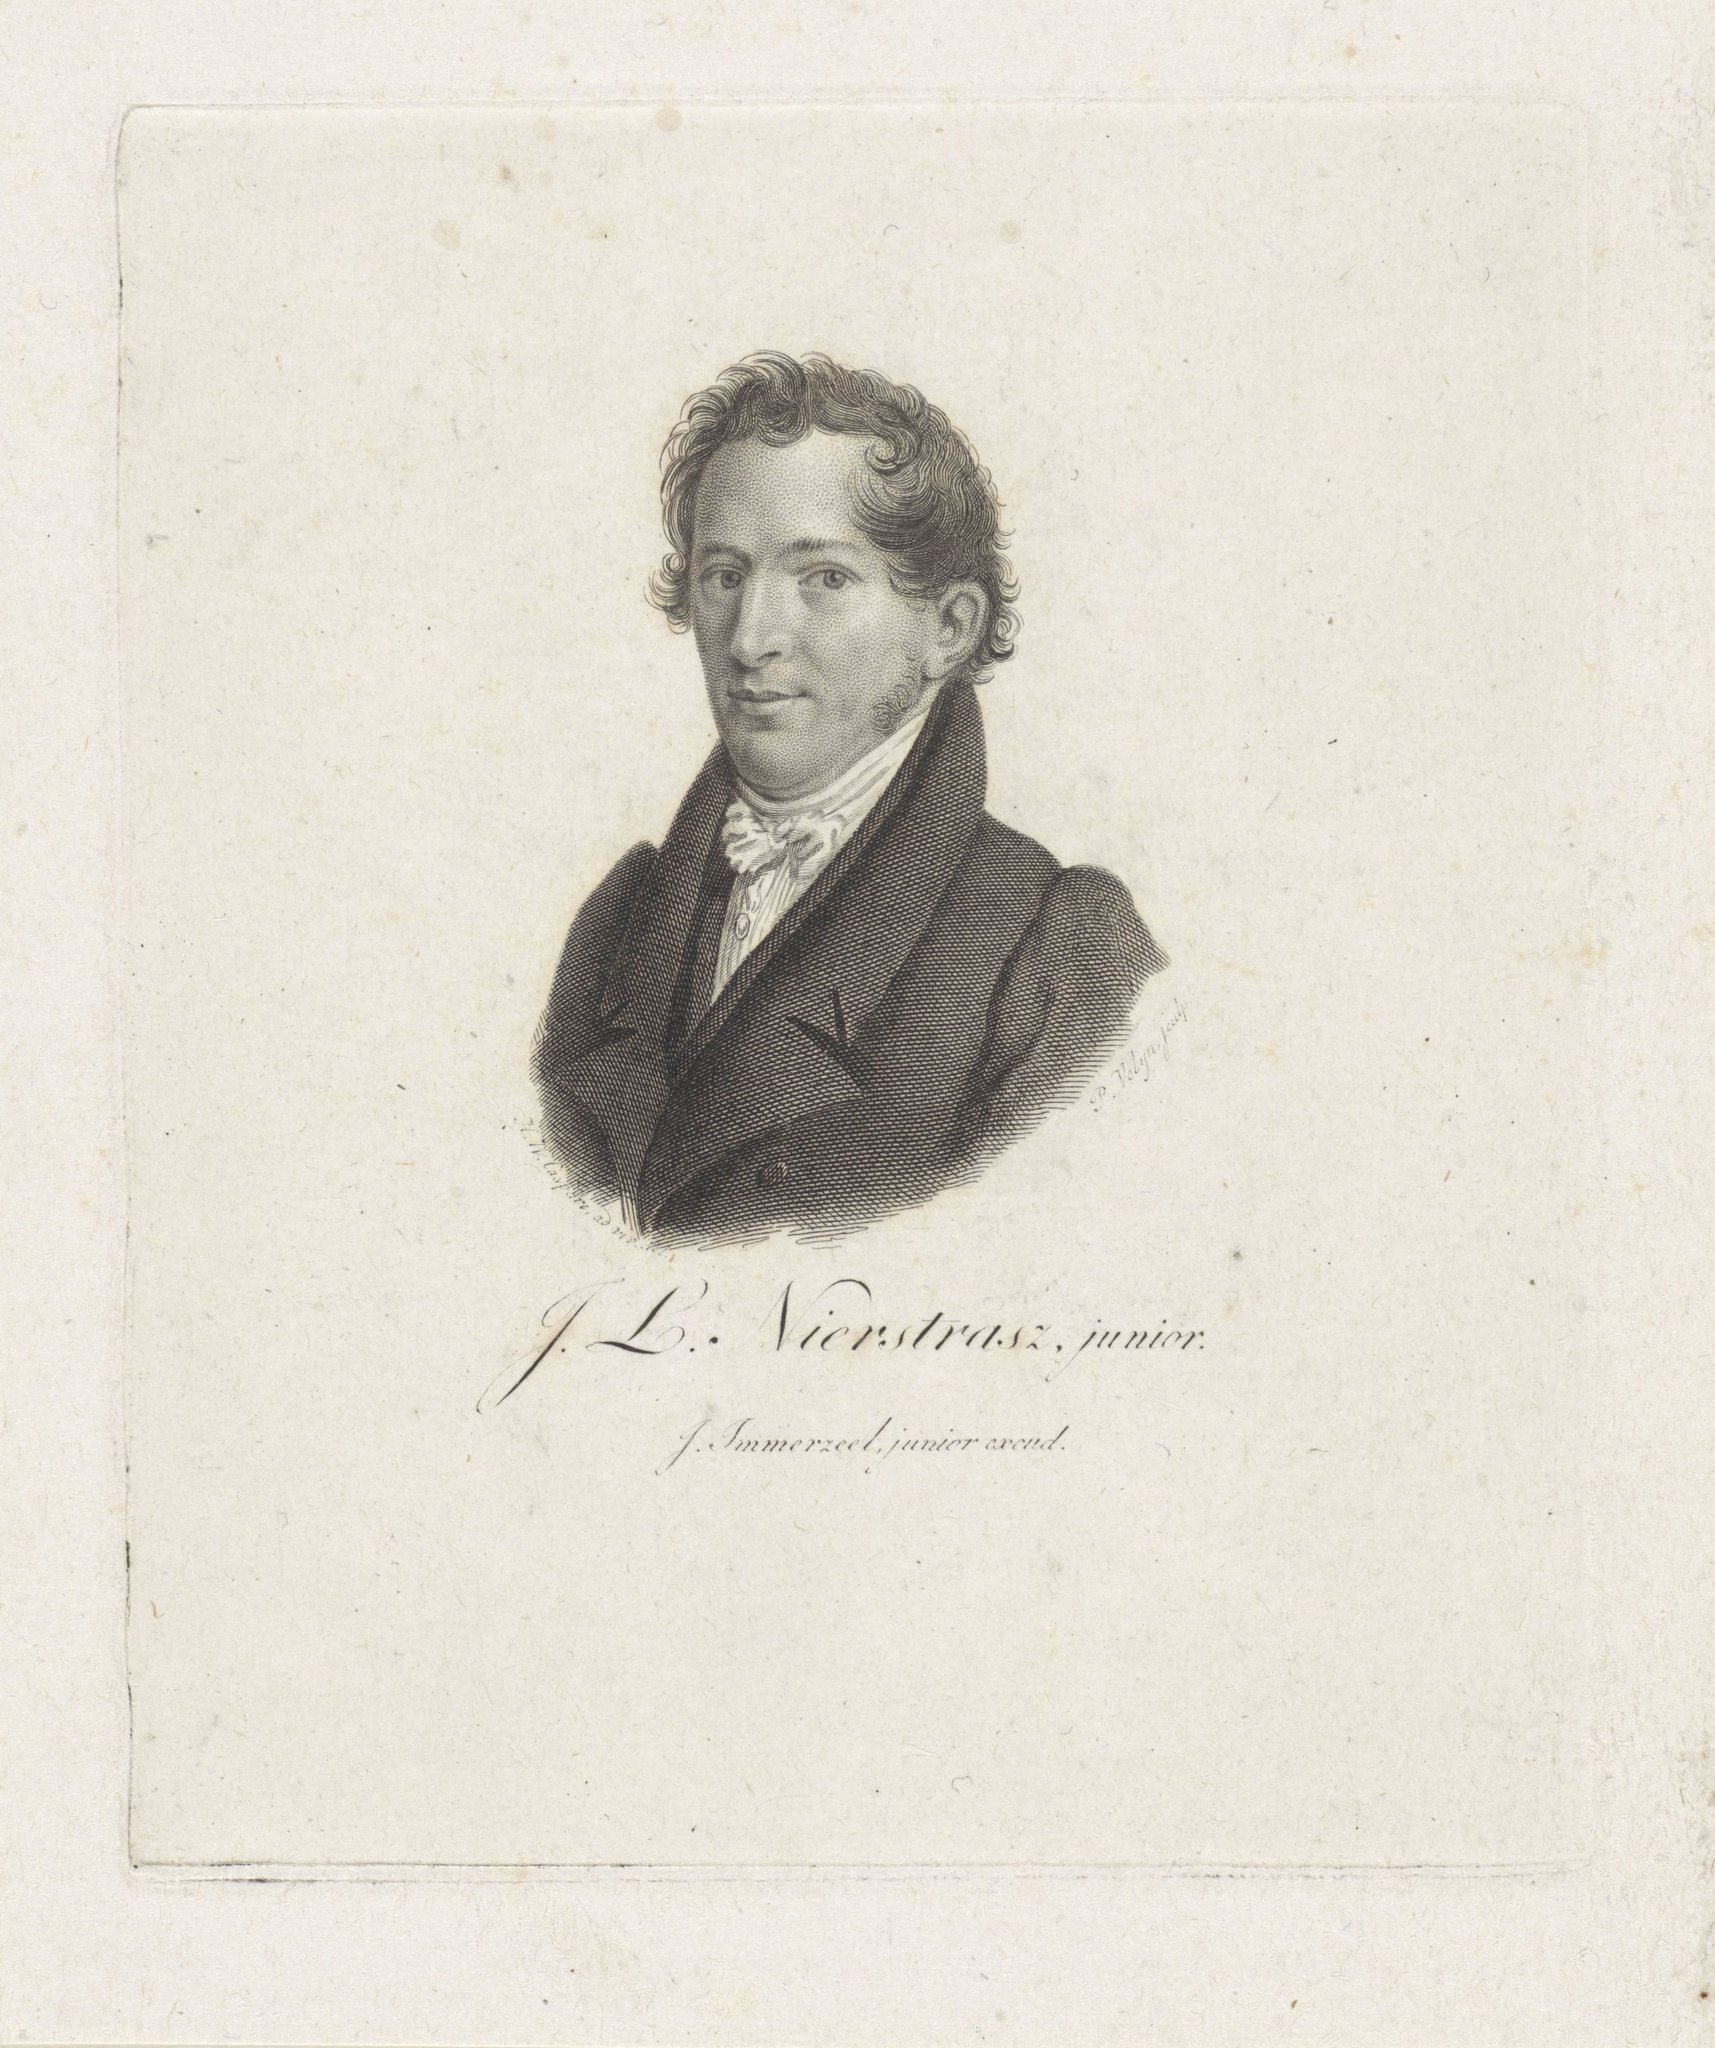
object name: print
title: Portret van Johannes Leonardus Nierstrasz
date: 1828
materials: paper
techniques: engraving, etching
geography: netherlands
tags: rotterdam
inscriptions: collector's mark: Lugt 2228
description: Prent volgens Van Someren ook gebruikt in: Nederlandsche Muzen-Almanak. Rotterdam: J. Immerzeel, 1828.